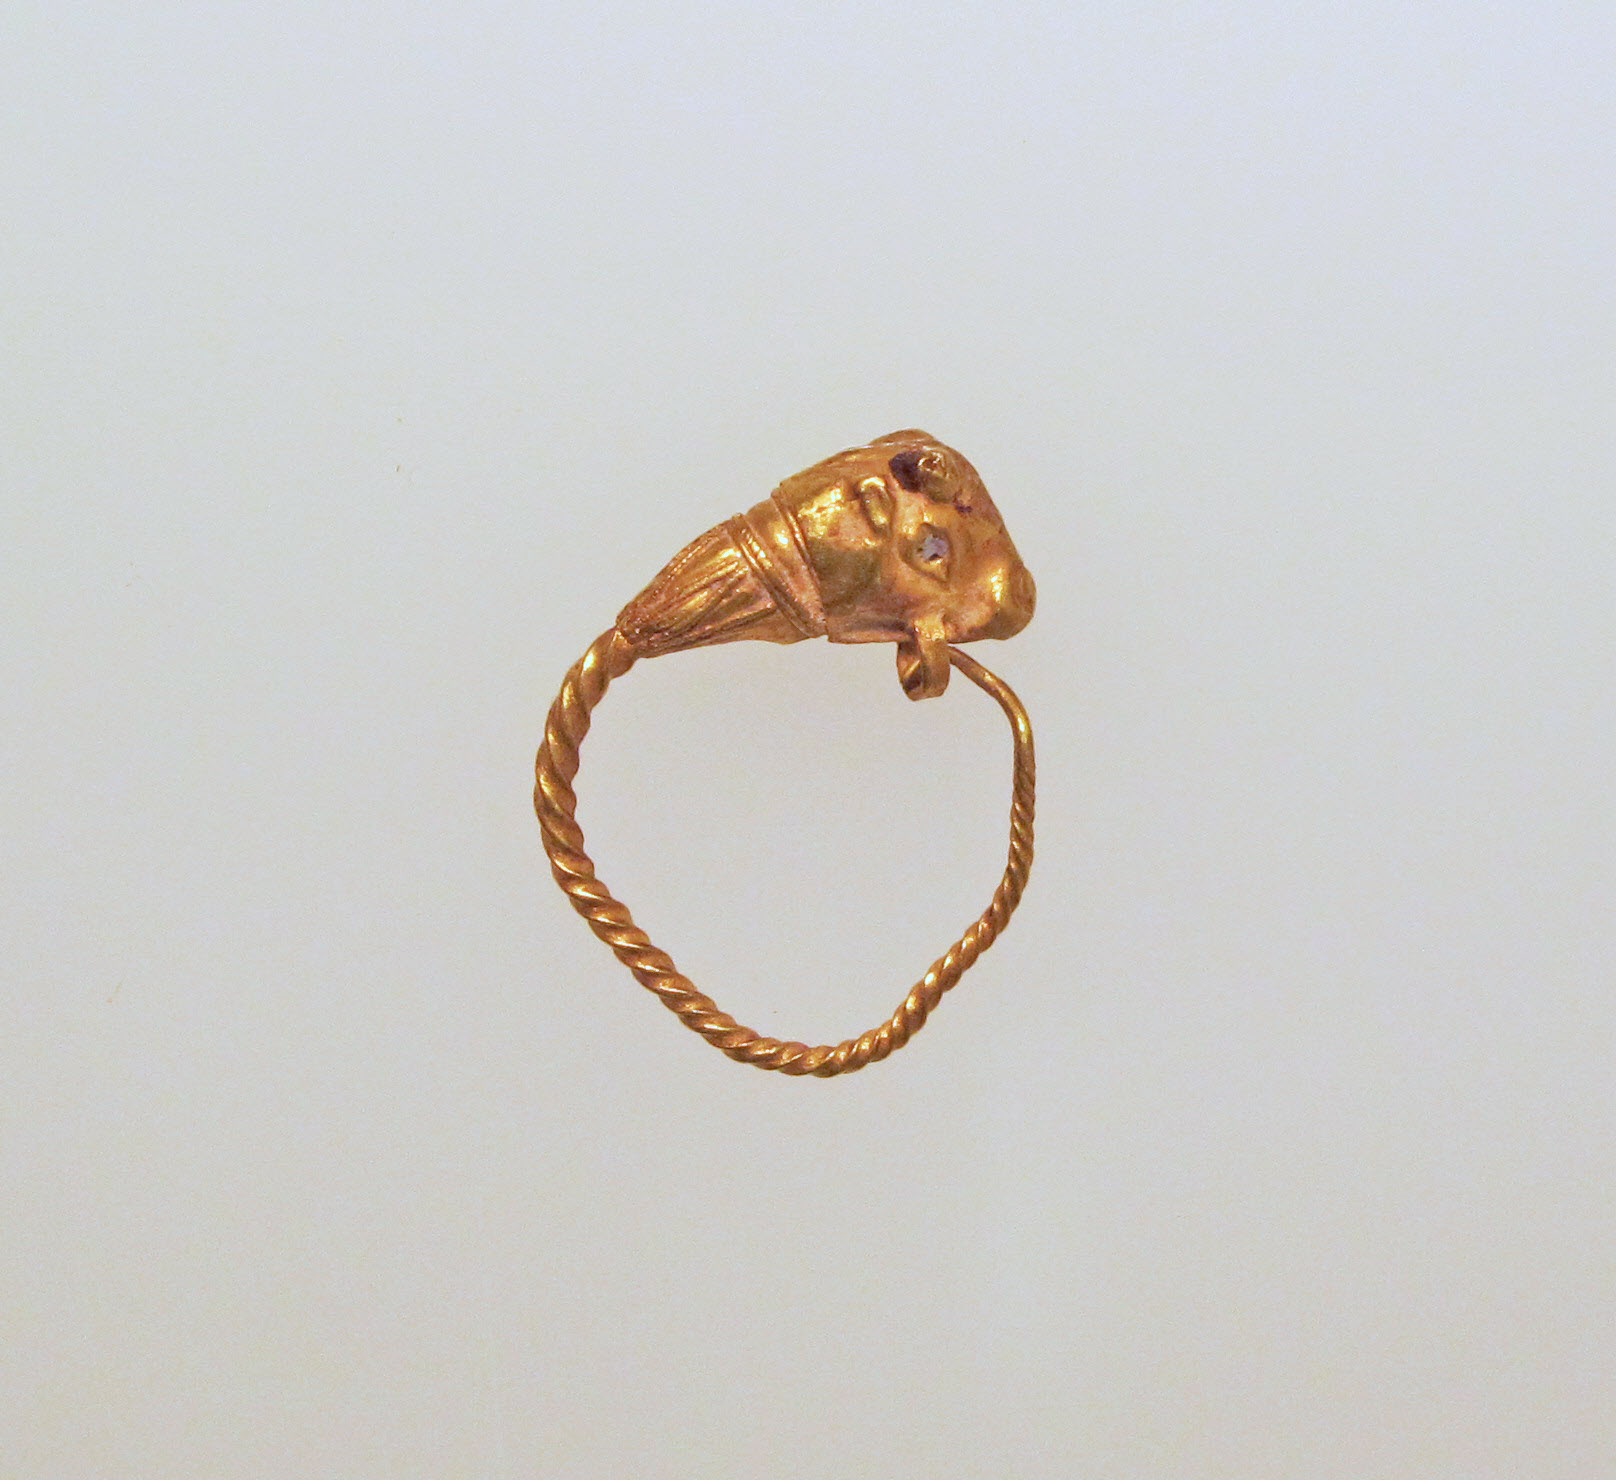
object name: earring with head of bull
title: Gold earring with head of a bull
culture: greek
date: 400-201 BCE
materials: gold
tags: bulls